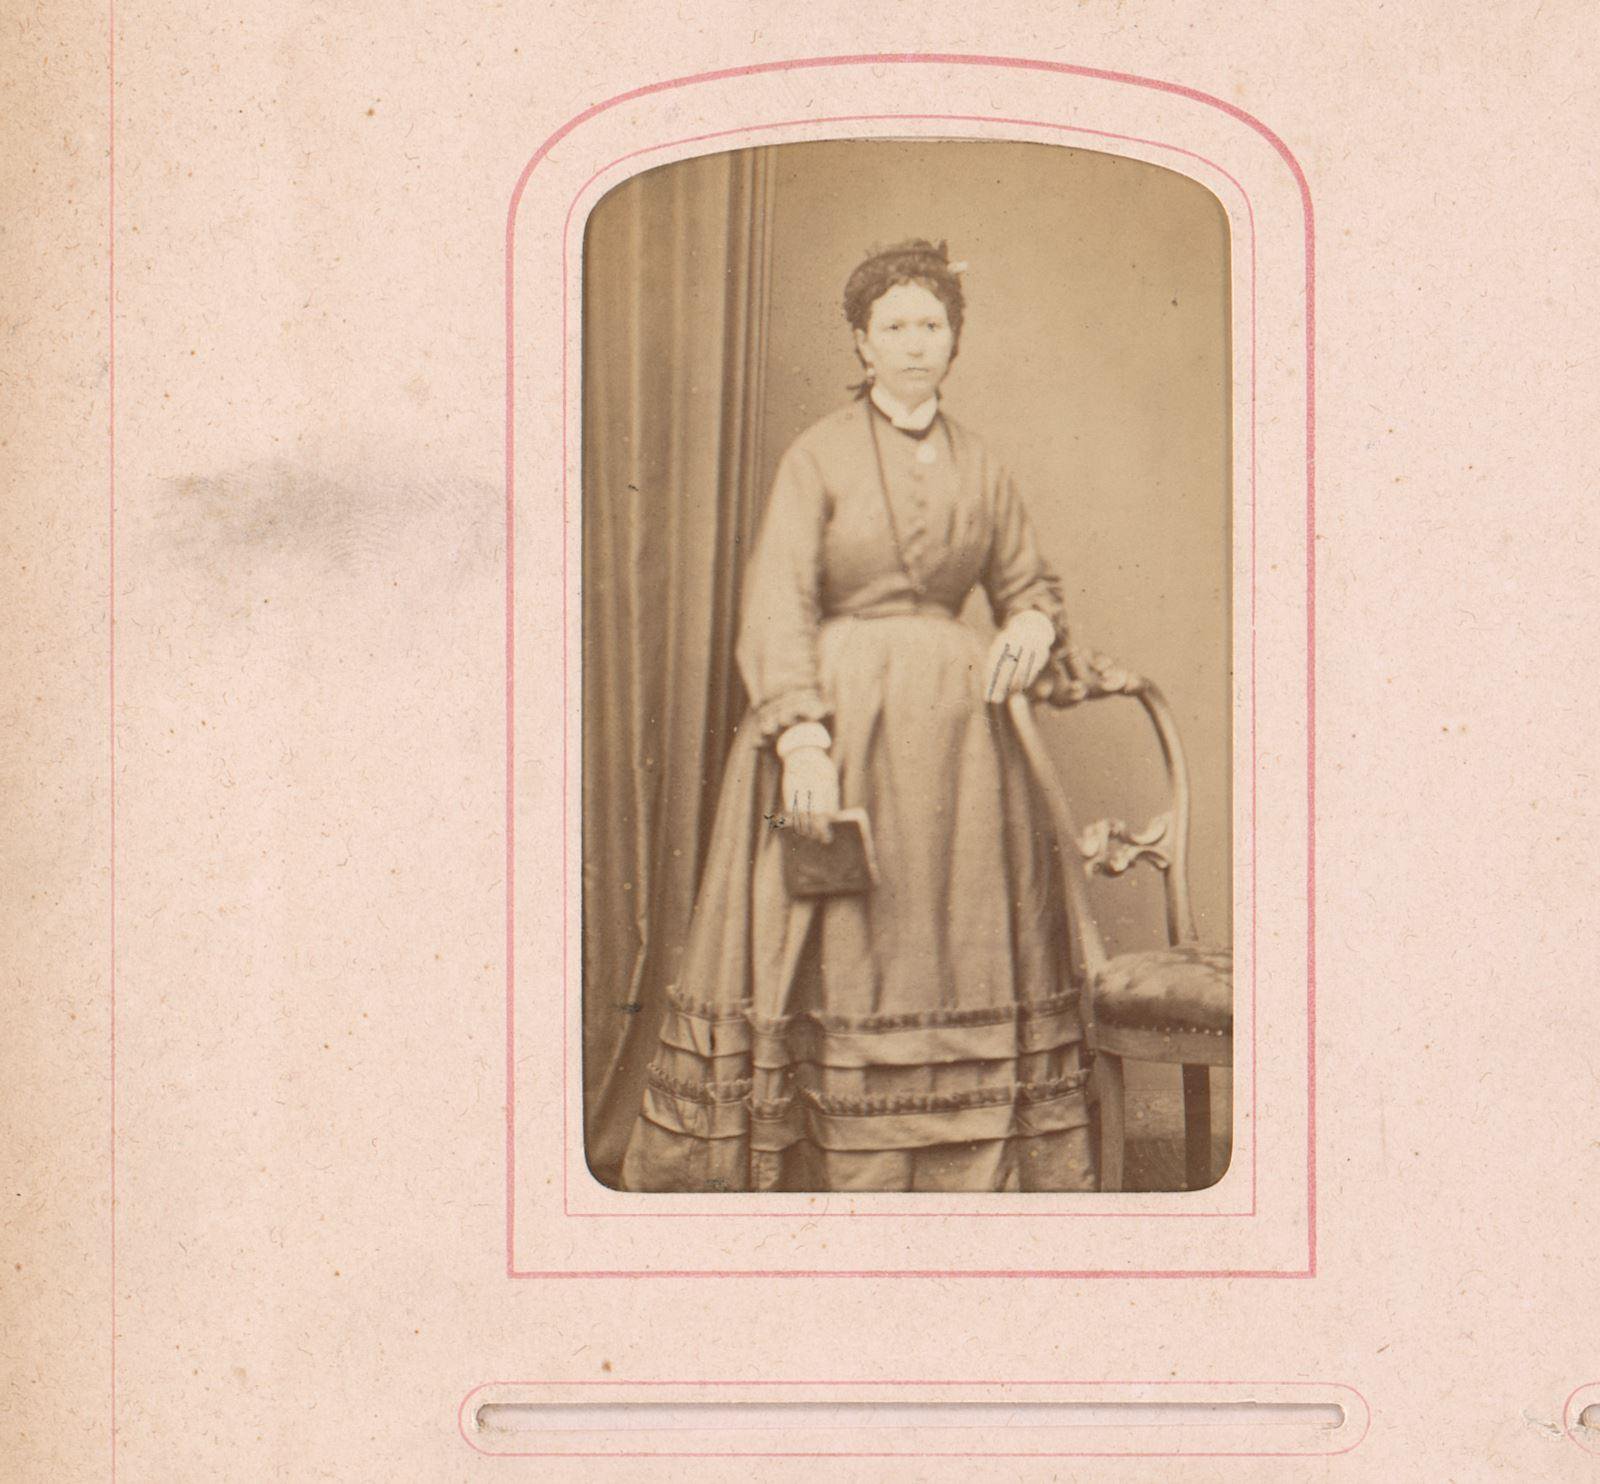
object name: carte de visite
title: Portret van een staande vrouw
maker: bernardus petrus rabels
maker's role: fotograaf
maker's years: 1824-1906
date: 1870-1893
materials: cardboard, paper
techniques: albumen print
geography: amsterdam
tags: adult woman, historical persons, amsterdam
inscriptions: inscription: ‘Photographisch Atelier/ van/ B.P. Rabels/ Prinsengracht bij de Leliestraat MM 138./ Amsterdam.’